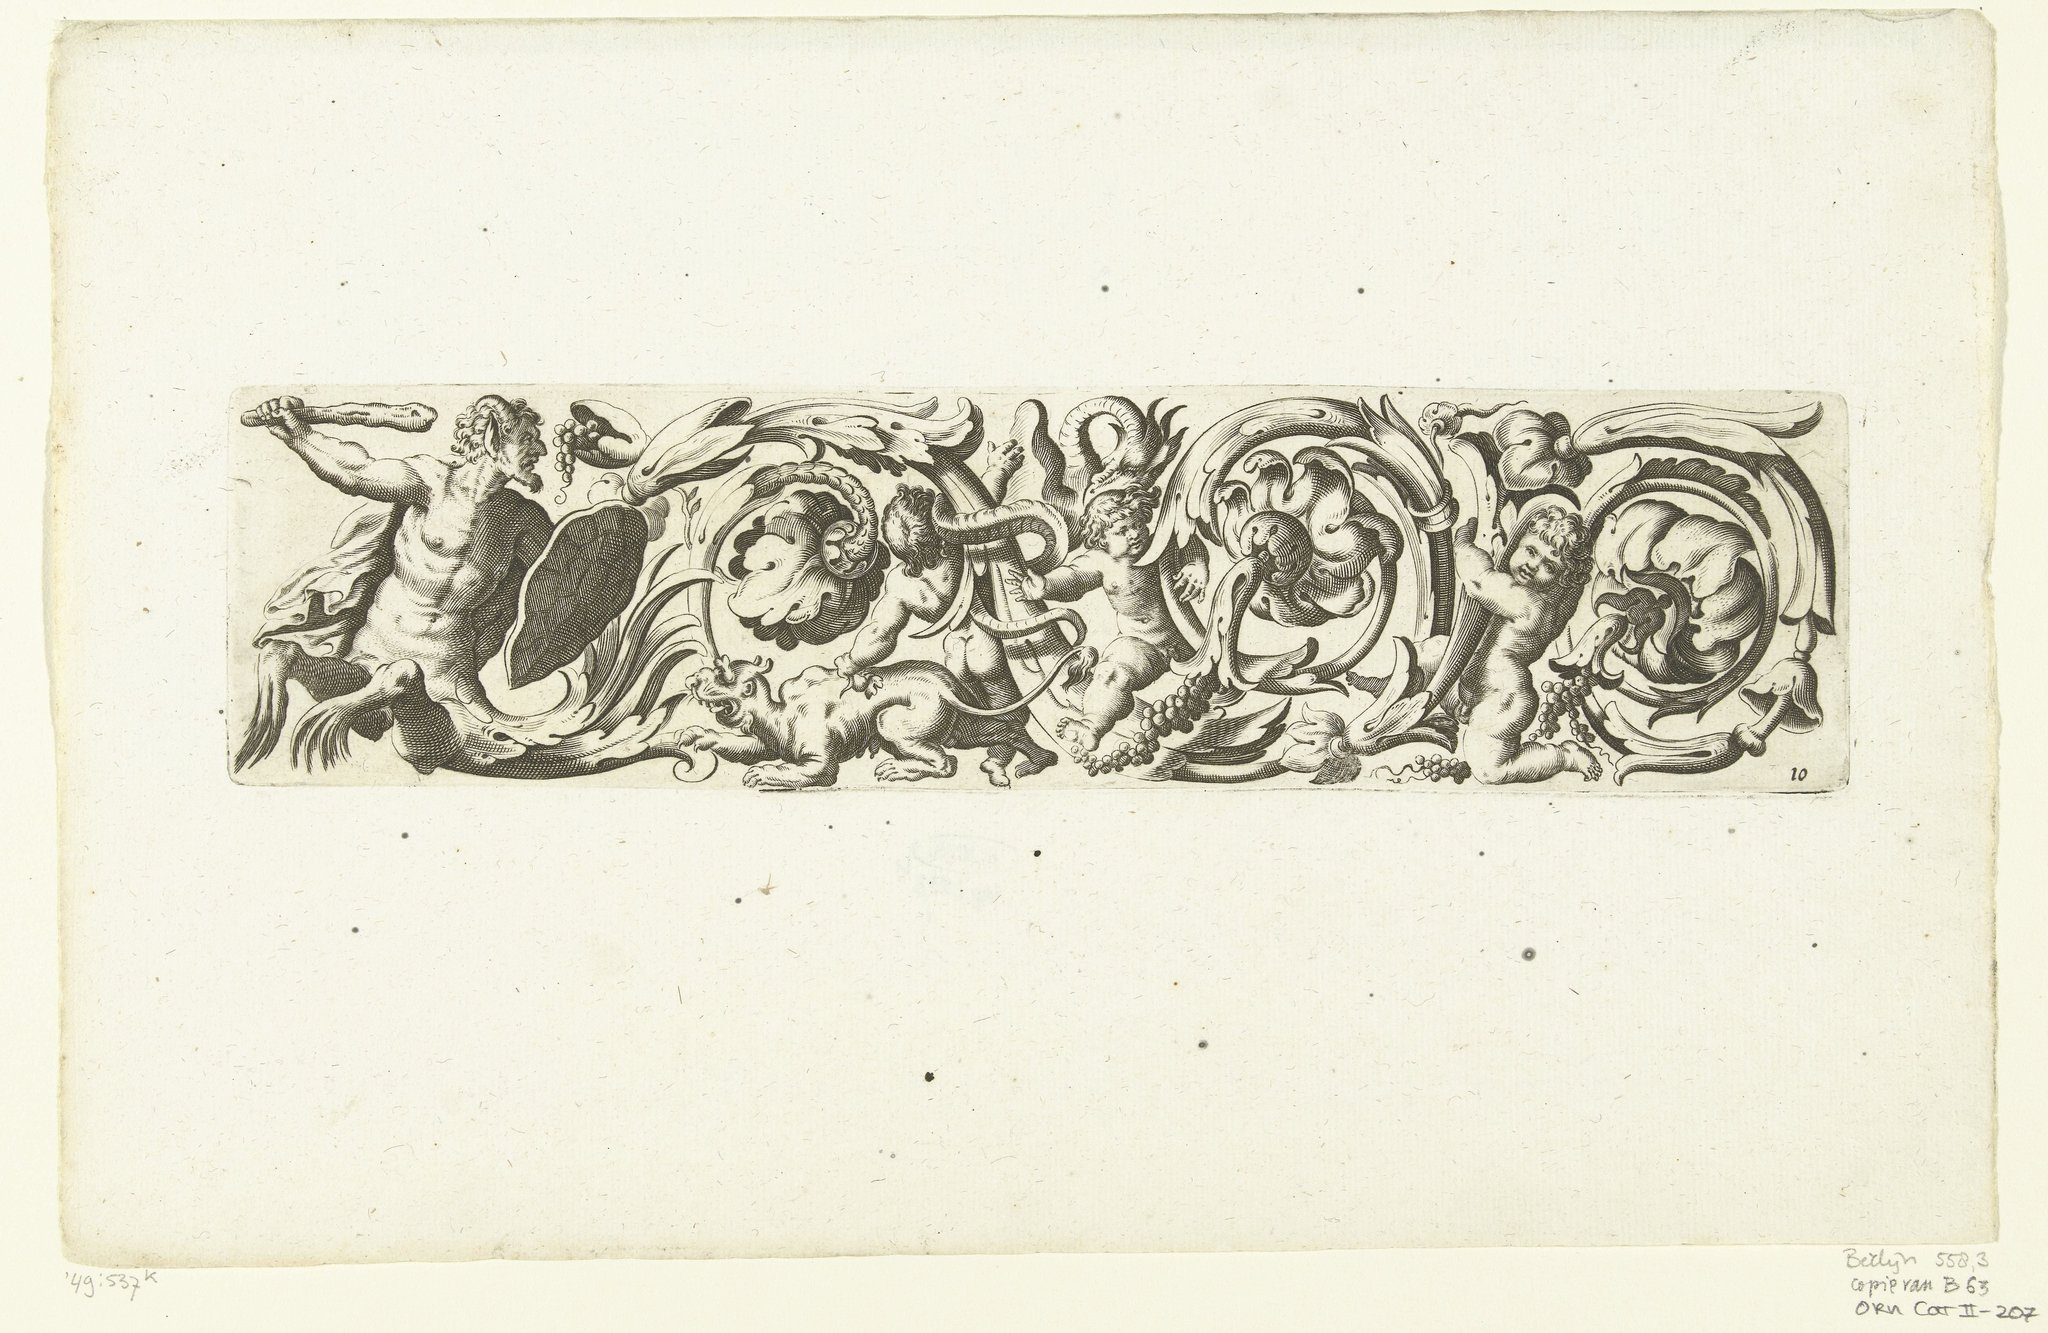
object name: ornament print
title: Verscheyden Aerdige Morissen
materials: paper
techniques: engraving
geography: amsterdam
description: Links een sater die een knots en een schild vasthoudt.